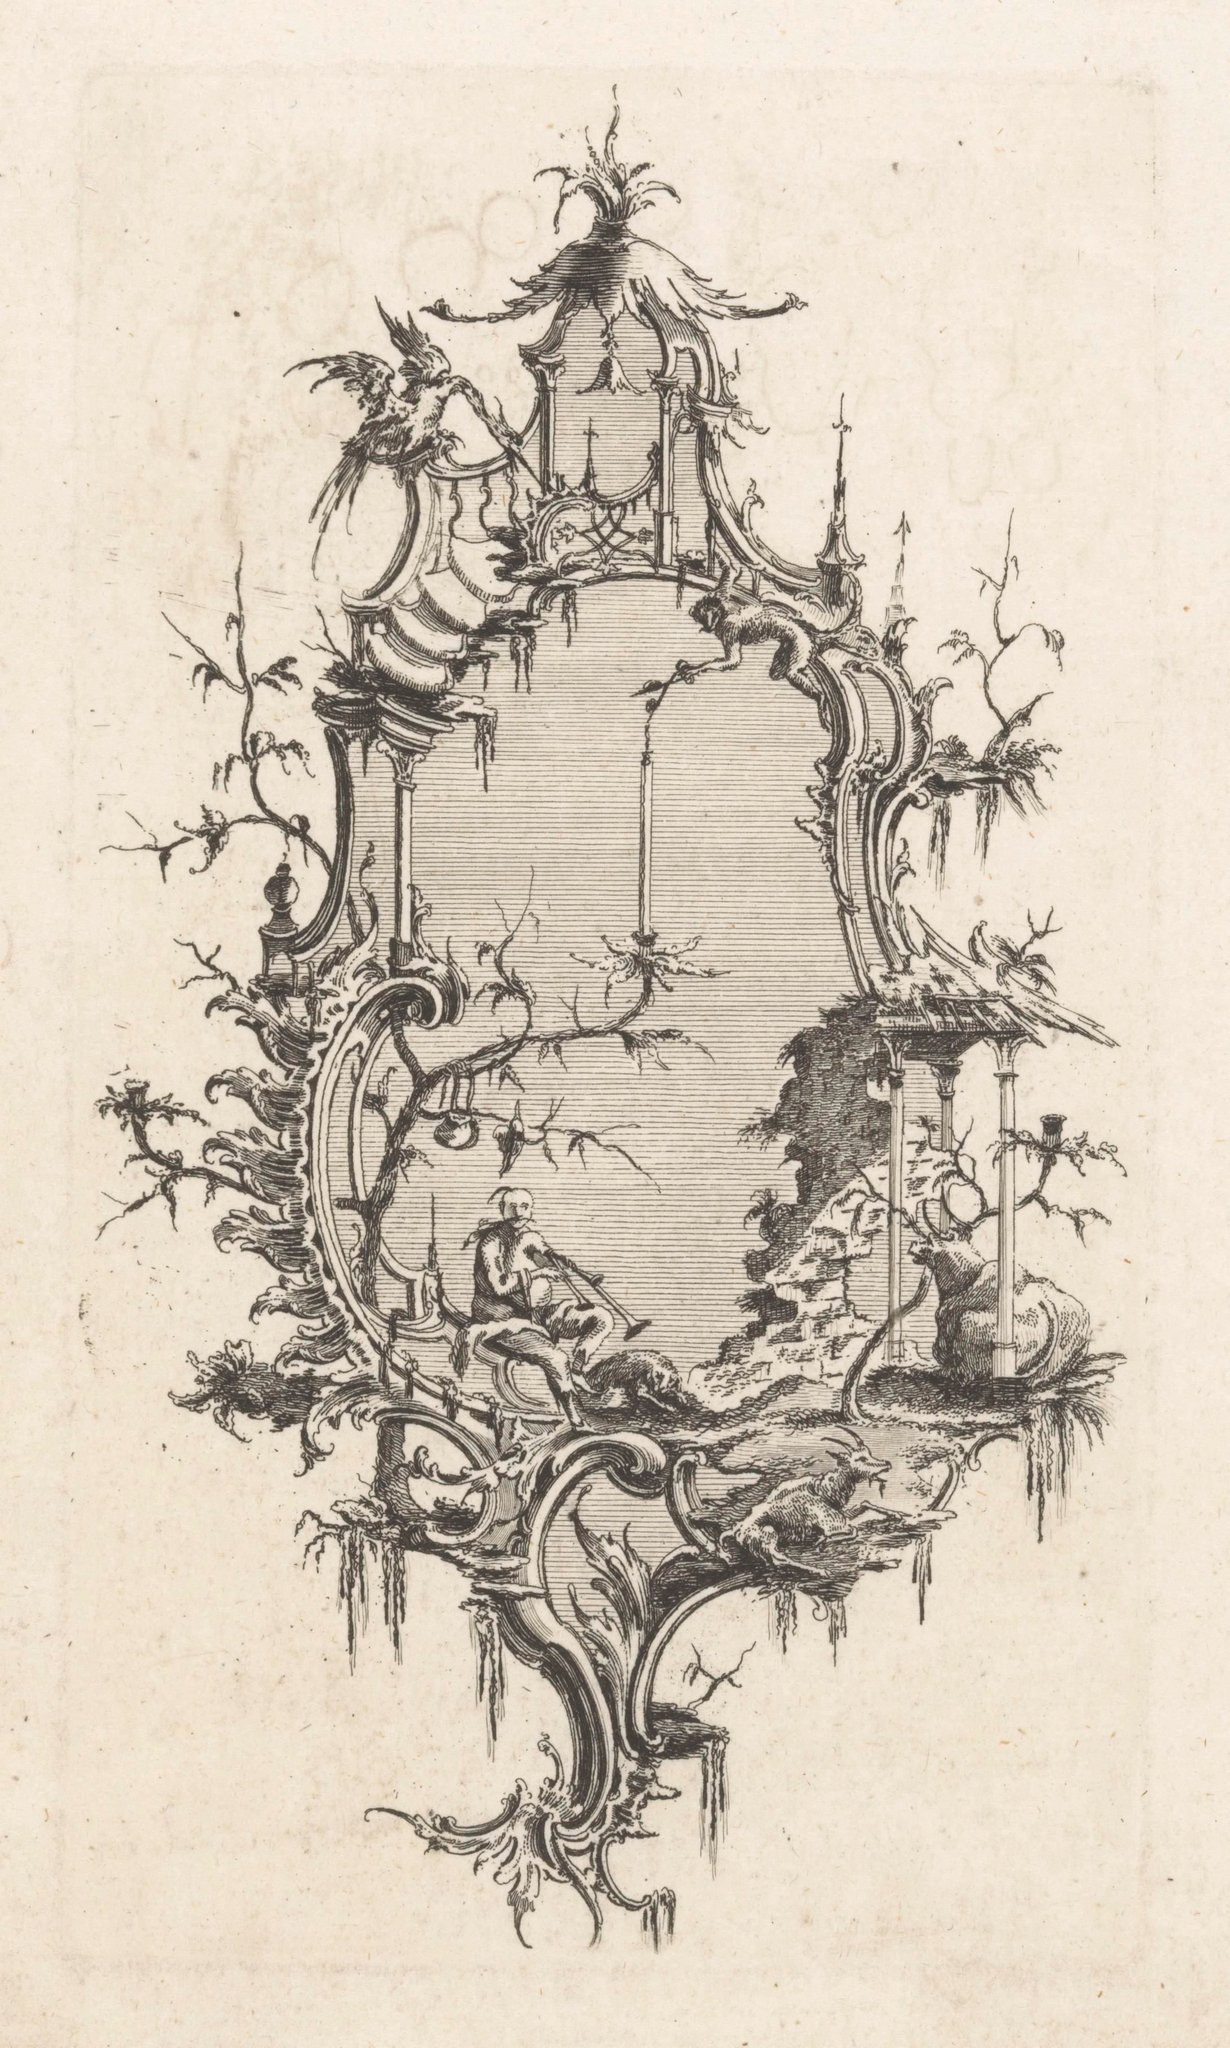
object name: ornament print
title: Girandole met doedelzakspelende man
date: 1755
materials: paper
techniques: engraving, etching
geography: london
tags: animals, bagpipe, musette, chandelier, candelabrum, one person playing an instrument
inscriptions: collector's mark: Lugt 2760, collector's mark: Lugt 2228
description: Een geornamenteerde girandole met in het midden een doedelzakspelende oosters uitziende man. Rondom hem diverse dieren zoals een hond, rund, aap en vogel.